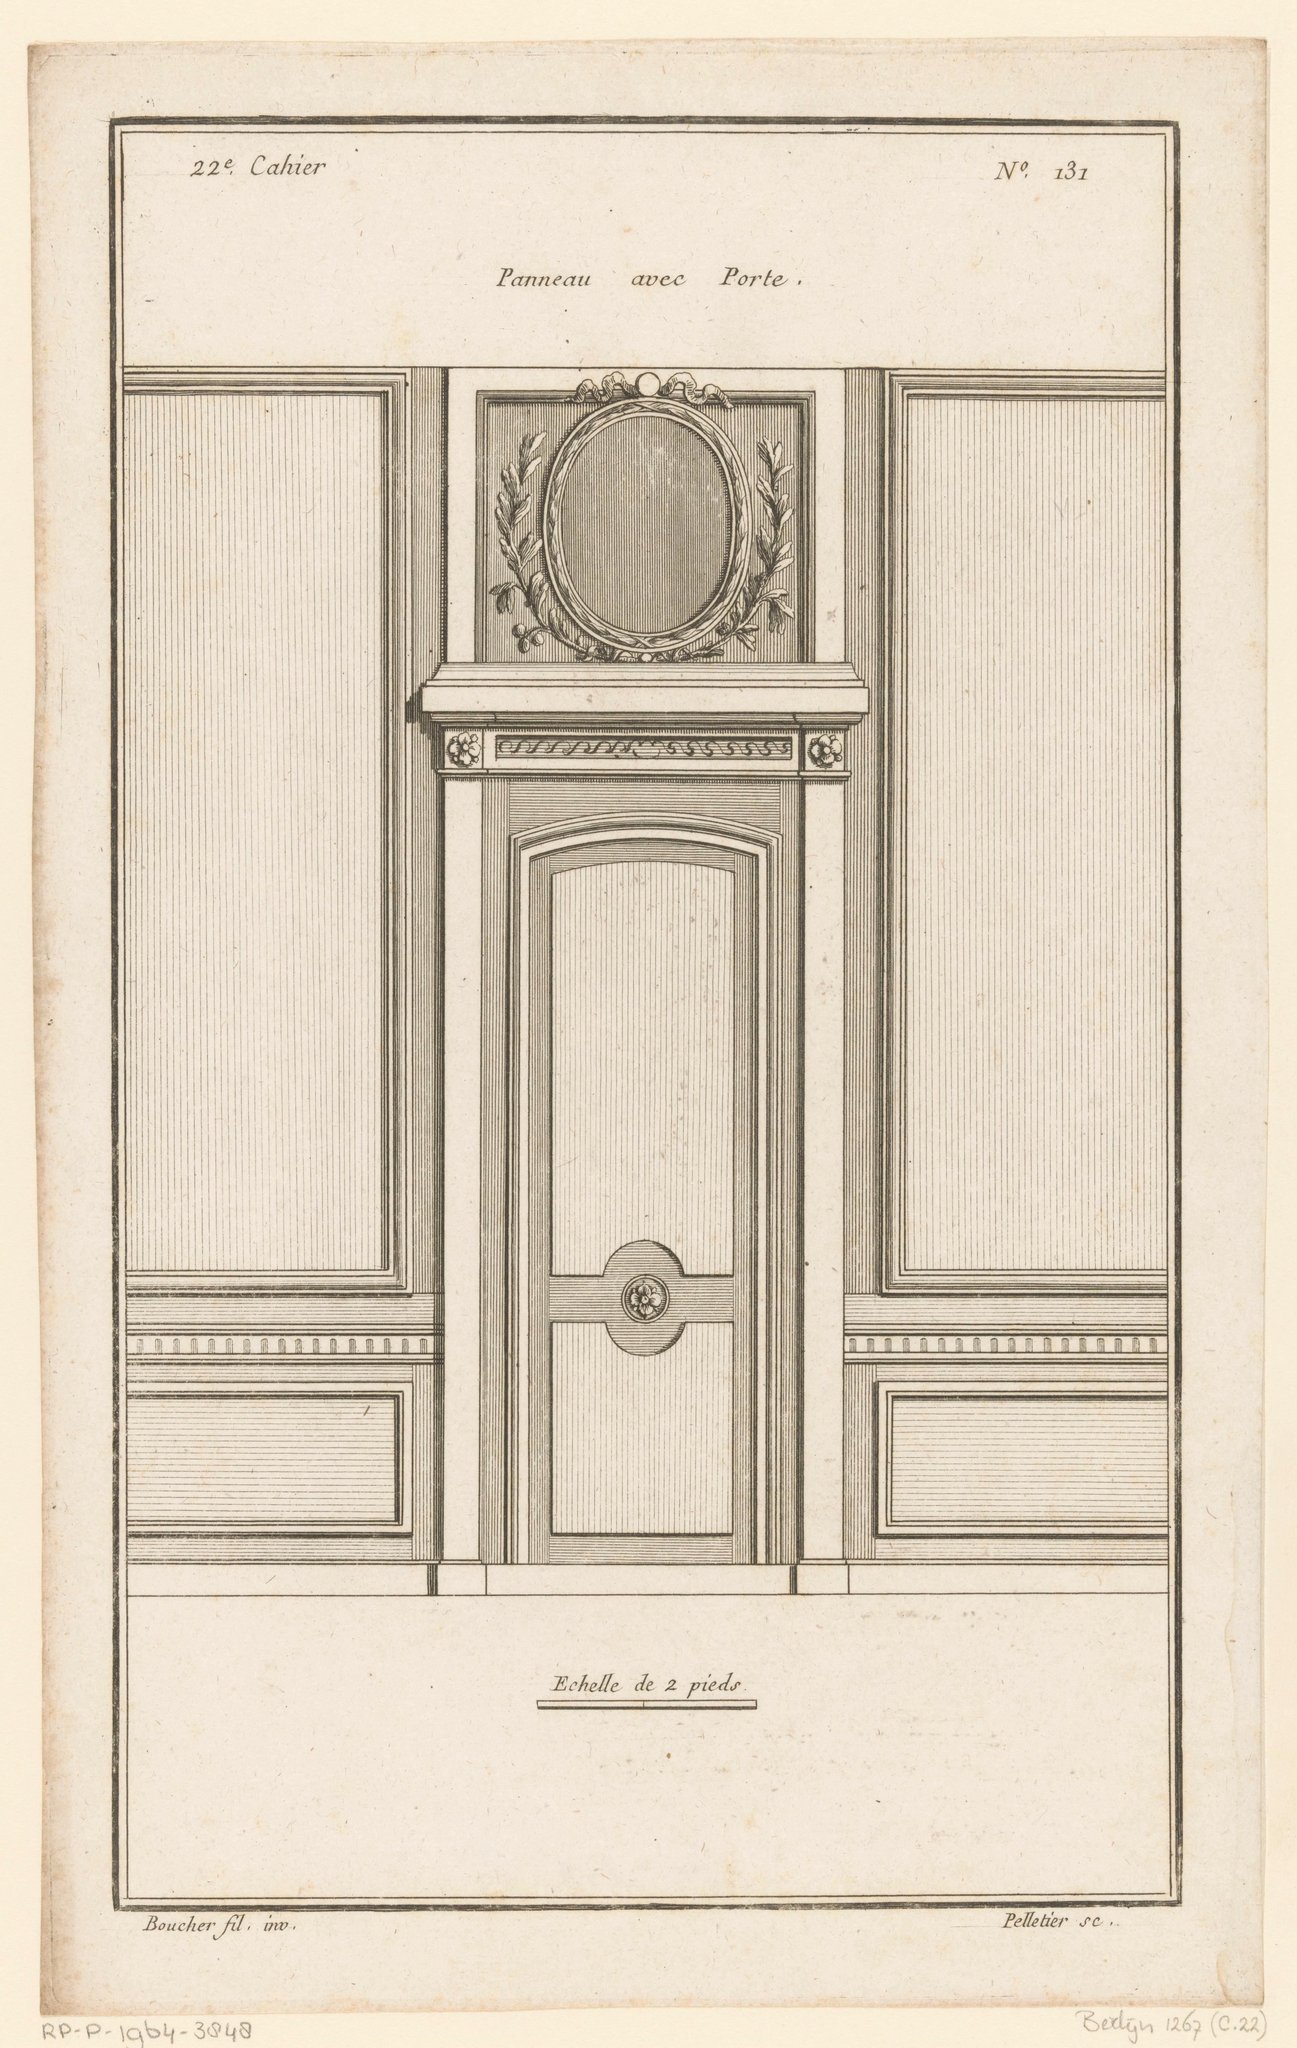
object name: ornament print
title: Panelen en deuren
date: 1772-1779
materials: paper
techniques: engraving, etching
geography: paris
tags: panelling, ornament ~ medallion, door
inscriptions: collector's mark: Lugt 2760, collector's mark: Lugt 2228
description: Wanddecoratie met een deur met bloemmotieven en aan weerszijden panelen. Aan de bovenzijde een paneel met een ovaal medaillon en ranken. Prentnummer 131.